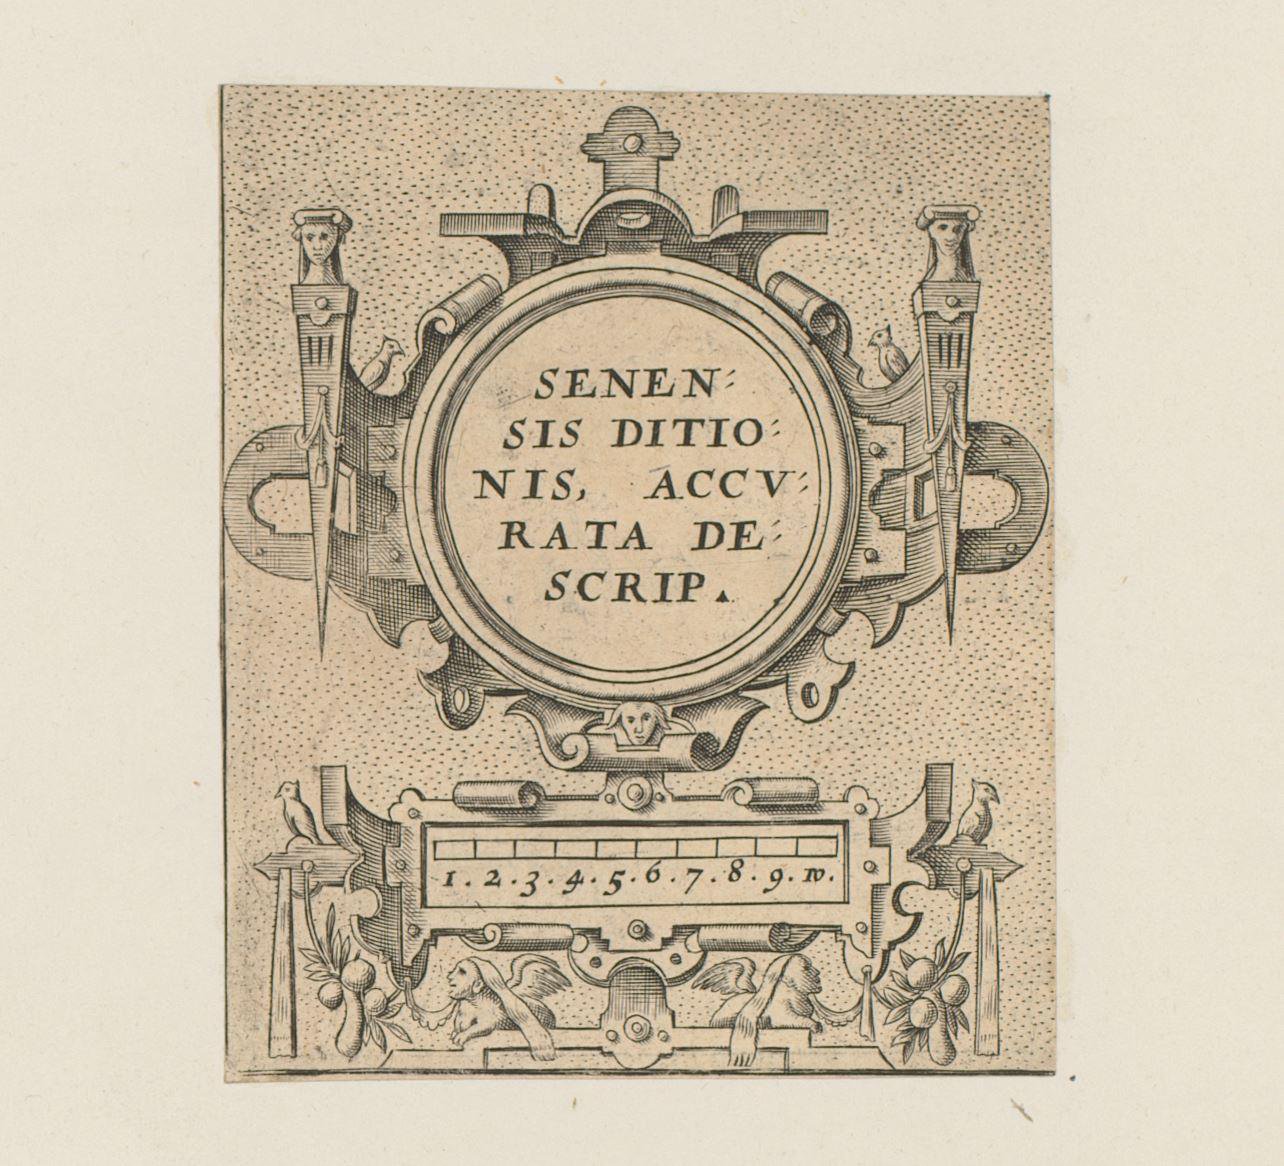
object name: print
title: Cartouche van een kaart van Siena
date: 1572-1575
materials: paper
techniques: engraving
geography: antwerp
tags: sphinx (lion/woman); 'sfinge' (ripa) - aa - female human figure, ornament ~ cartouche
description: Ronde cartouche geflankeerd door twee omgekeerde pyramides met een vrouwenbuste. Daaronder een rechthoekige cartouche met schaalstok en gedecoreerd met trossen fruit en twee sfinxen. Het ornament is een fragment van een kaart van Siena. De prent maakt deel uit van een album.